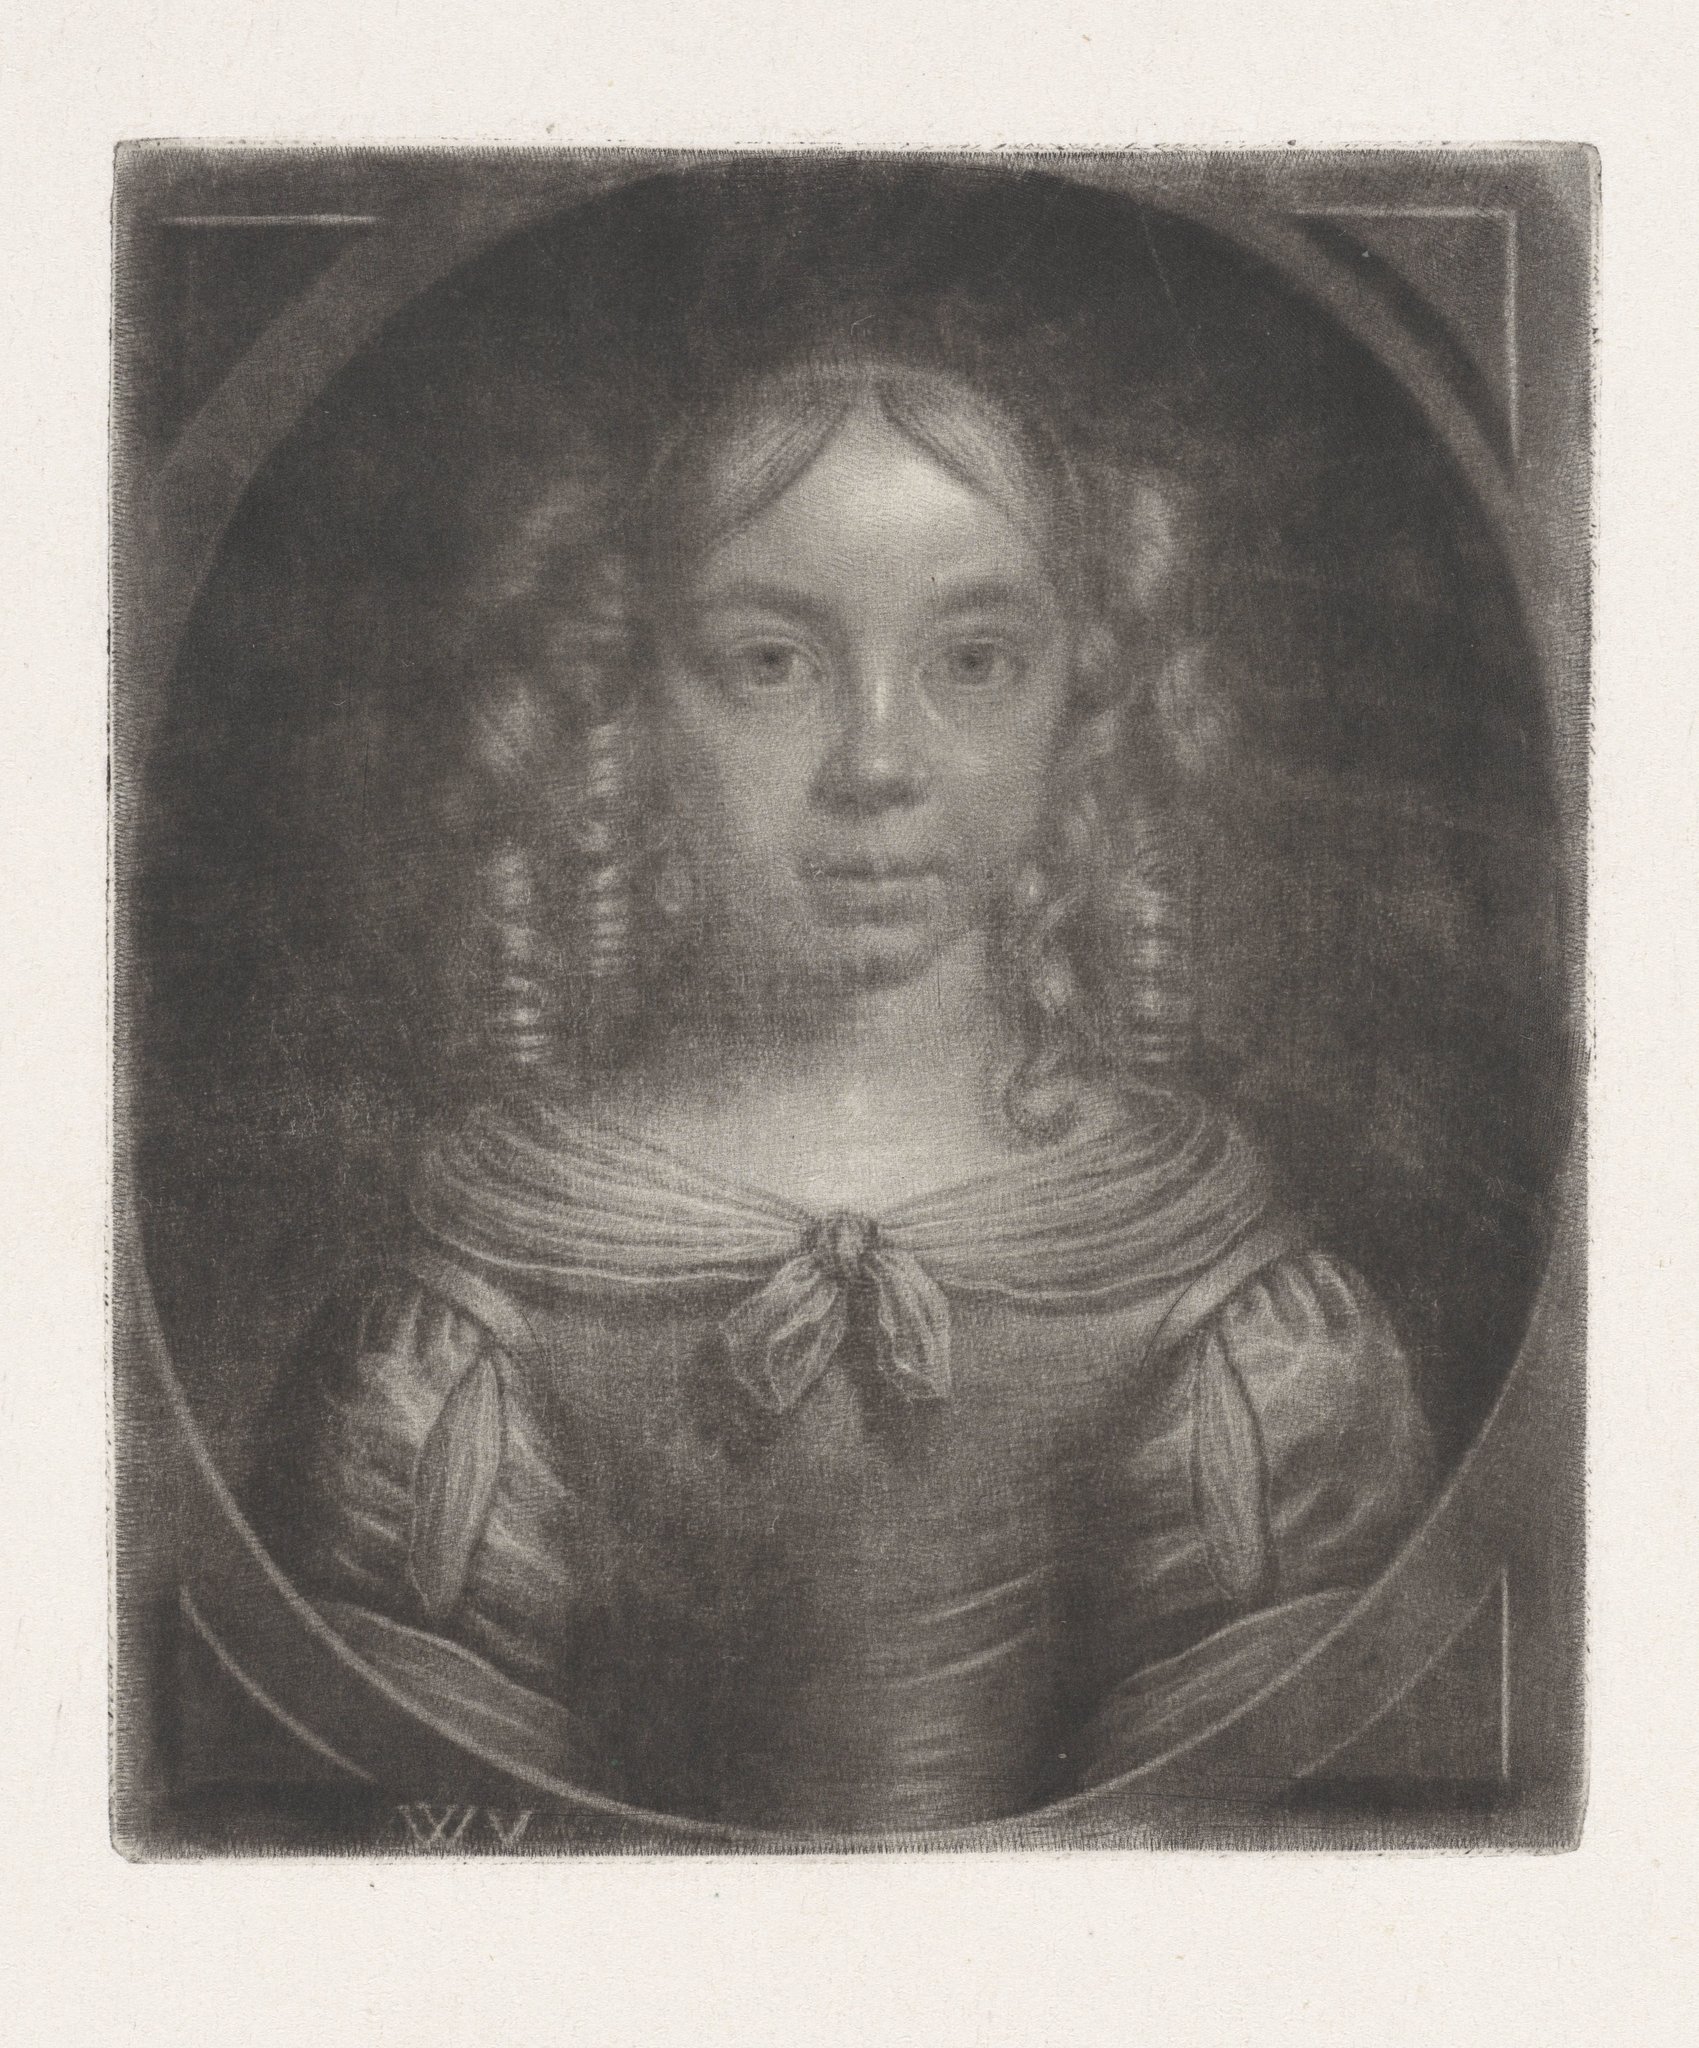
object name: print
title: Portret van een jong meisje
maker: wallerant vaillant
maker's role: draughtsman, painter, print maker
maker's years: 1623-1677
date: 1658-1677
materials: paper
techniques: mezzotint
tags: necklace (+ women's clothes)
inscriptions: collector's mark: Lugt 2228